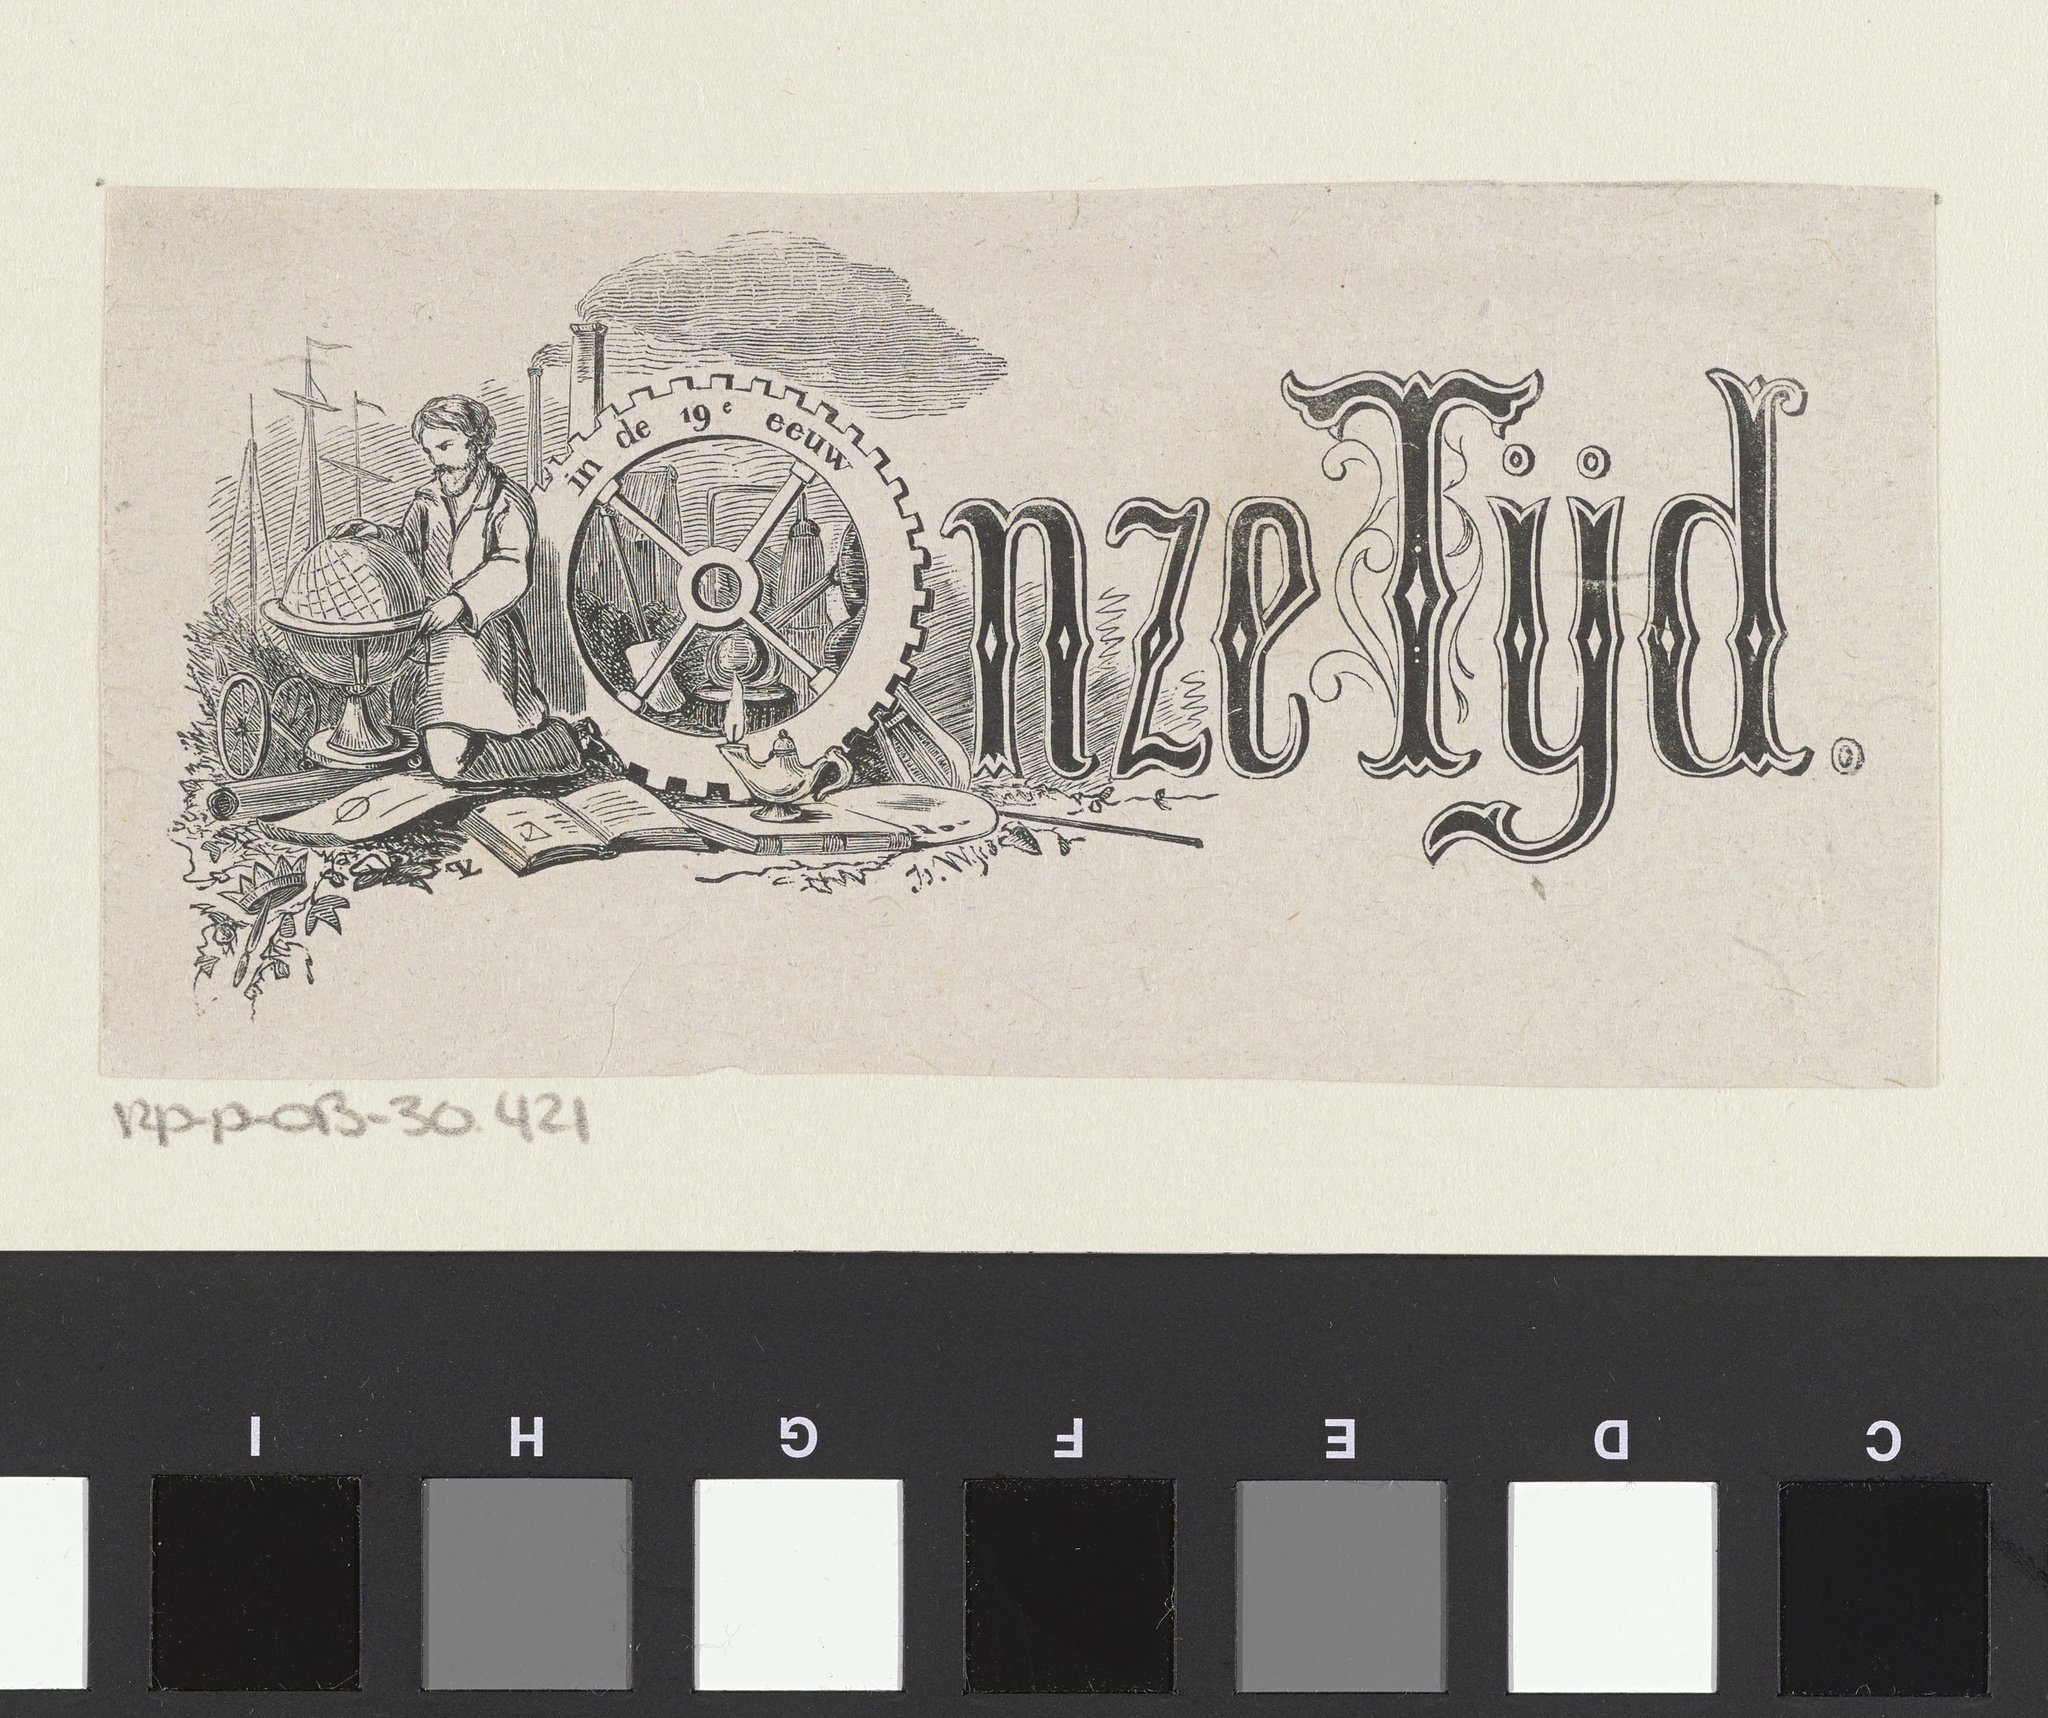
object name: print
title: Onze tijd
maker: isaac weissenbruch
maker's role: print maker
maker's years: 1826-1912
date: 1836-1912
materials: paper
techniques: engraving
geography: netherlands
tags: factory-building, globe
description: Een man zit geknield bij een globe. Om hem heen ligt een aantal objecten uit de negentiende eeuw, waaronder een tandwiel en een fabriek.